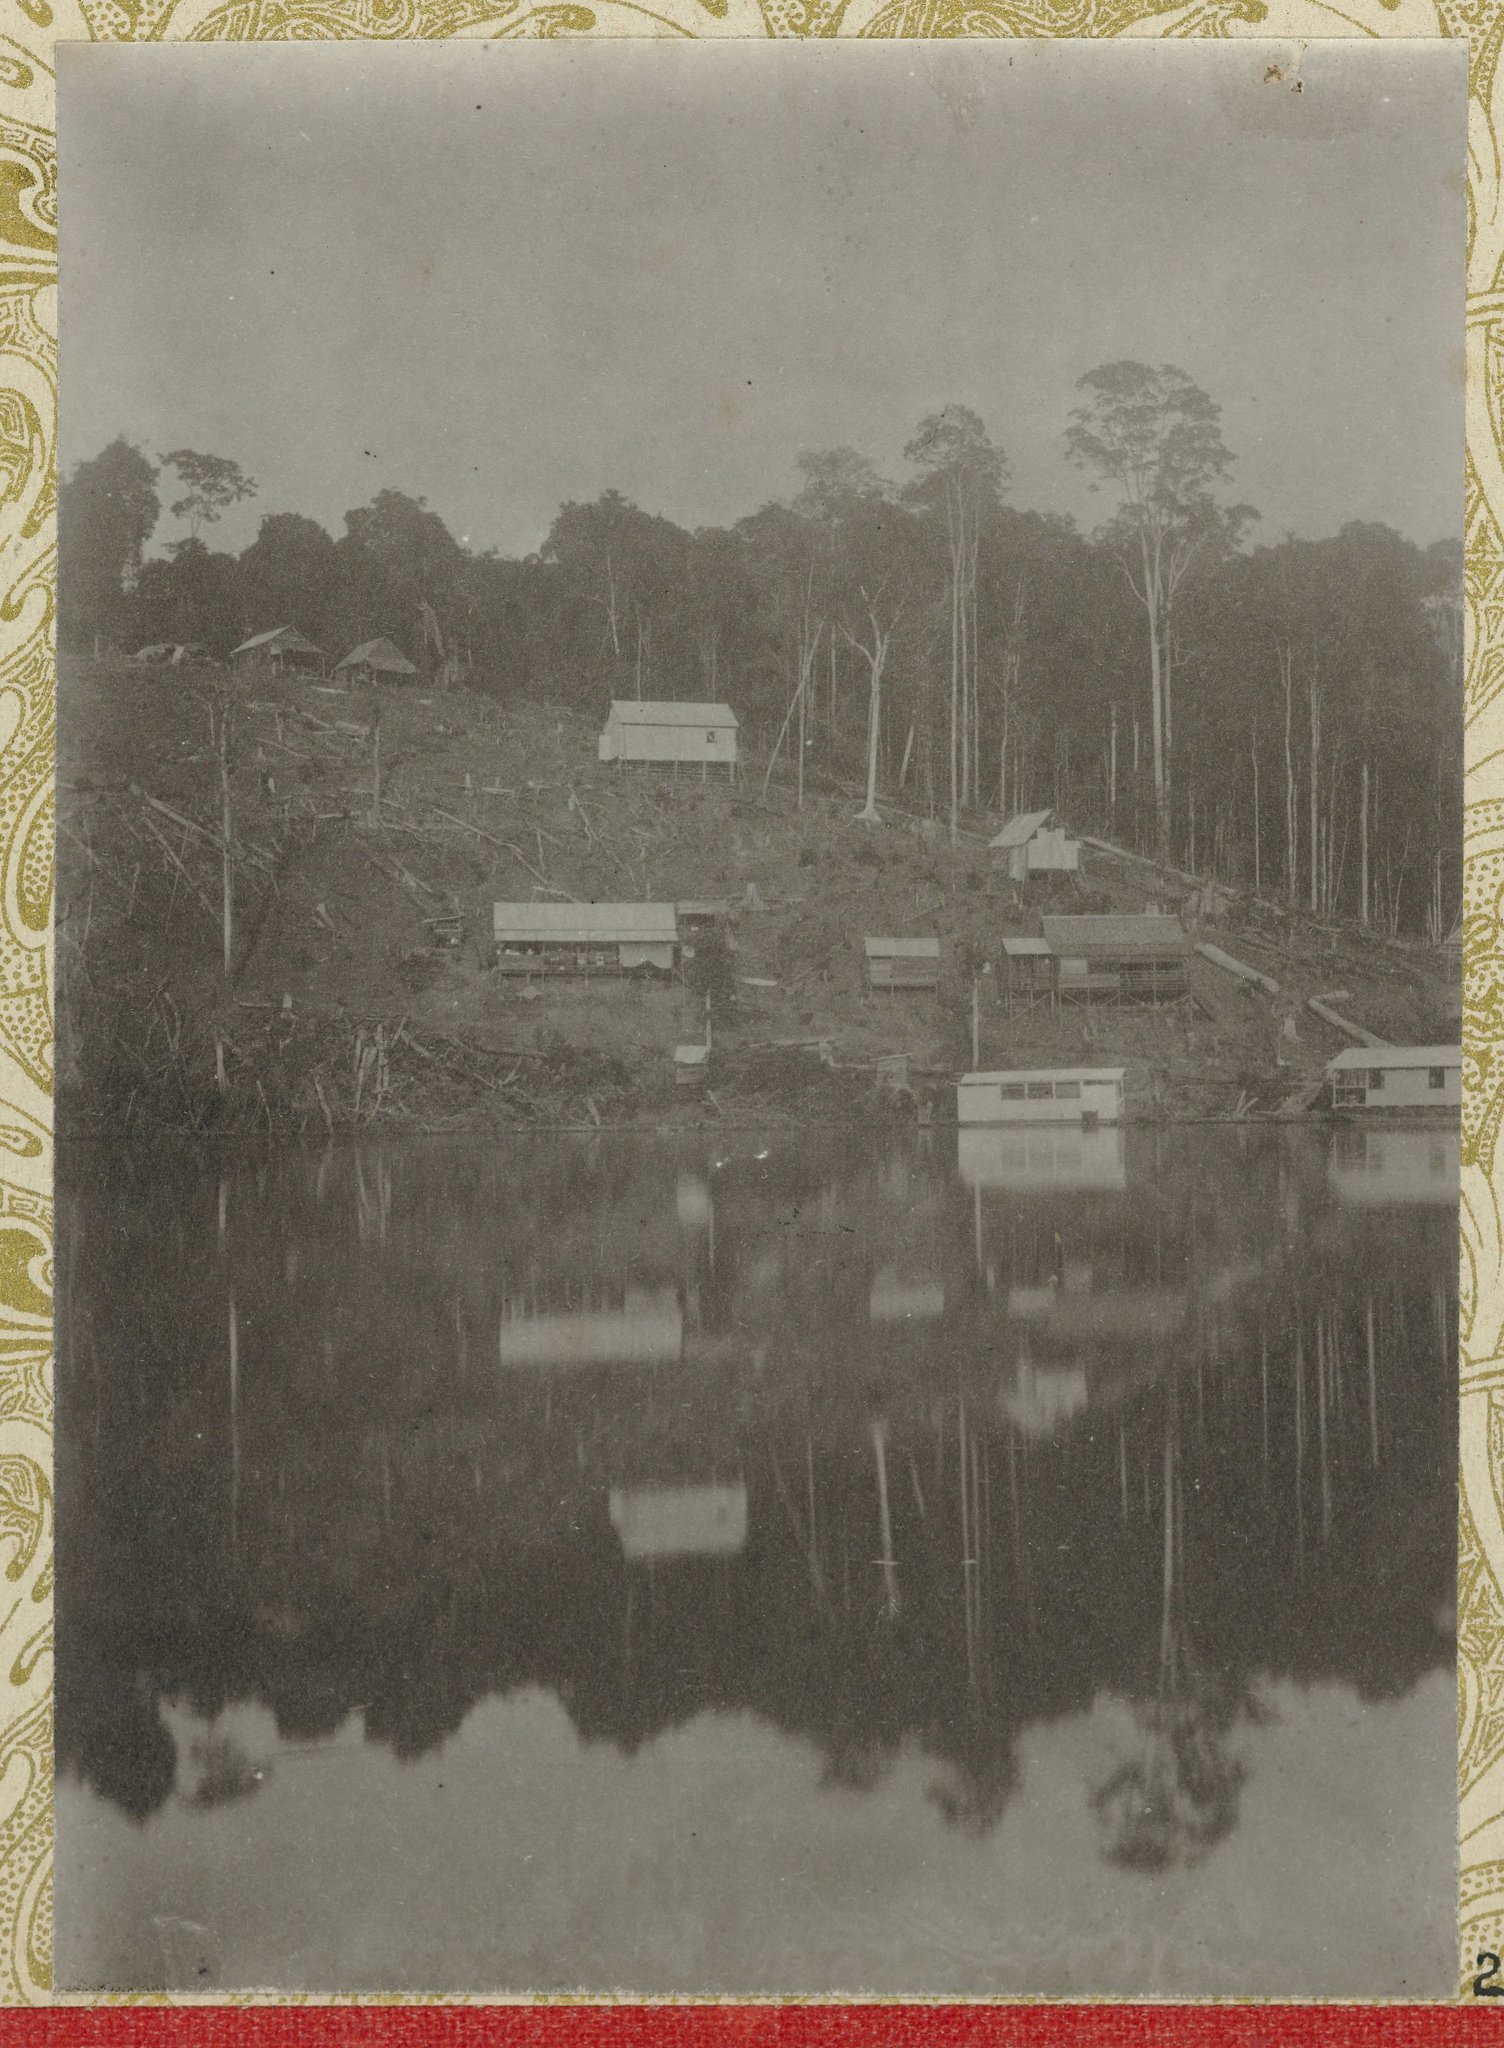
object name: photograph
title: Huizen bij de Maabo Heuvel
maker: hendrik doijer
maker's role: engineer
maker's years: 1863-1925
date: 1903-1910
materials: photographic support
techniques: gelatin silver print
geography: suriname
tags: suriname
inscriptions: inscription: ‘23’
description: Gezicht op huizen bij het water bij de Maäbo Heuvel, voor de afspuiting ten behoeve van de aanleg van de Lawaspoorweg (1903-1912). Onderdeel van het fotoalbum Souvenir de Voyage (deel 2), over het leven van de familie Doijer in en rond de plantage Ma Retraite in Suriname in de jaren 1903-1910.